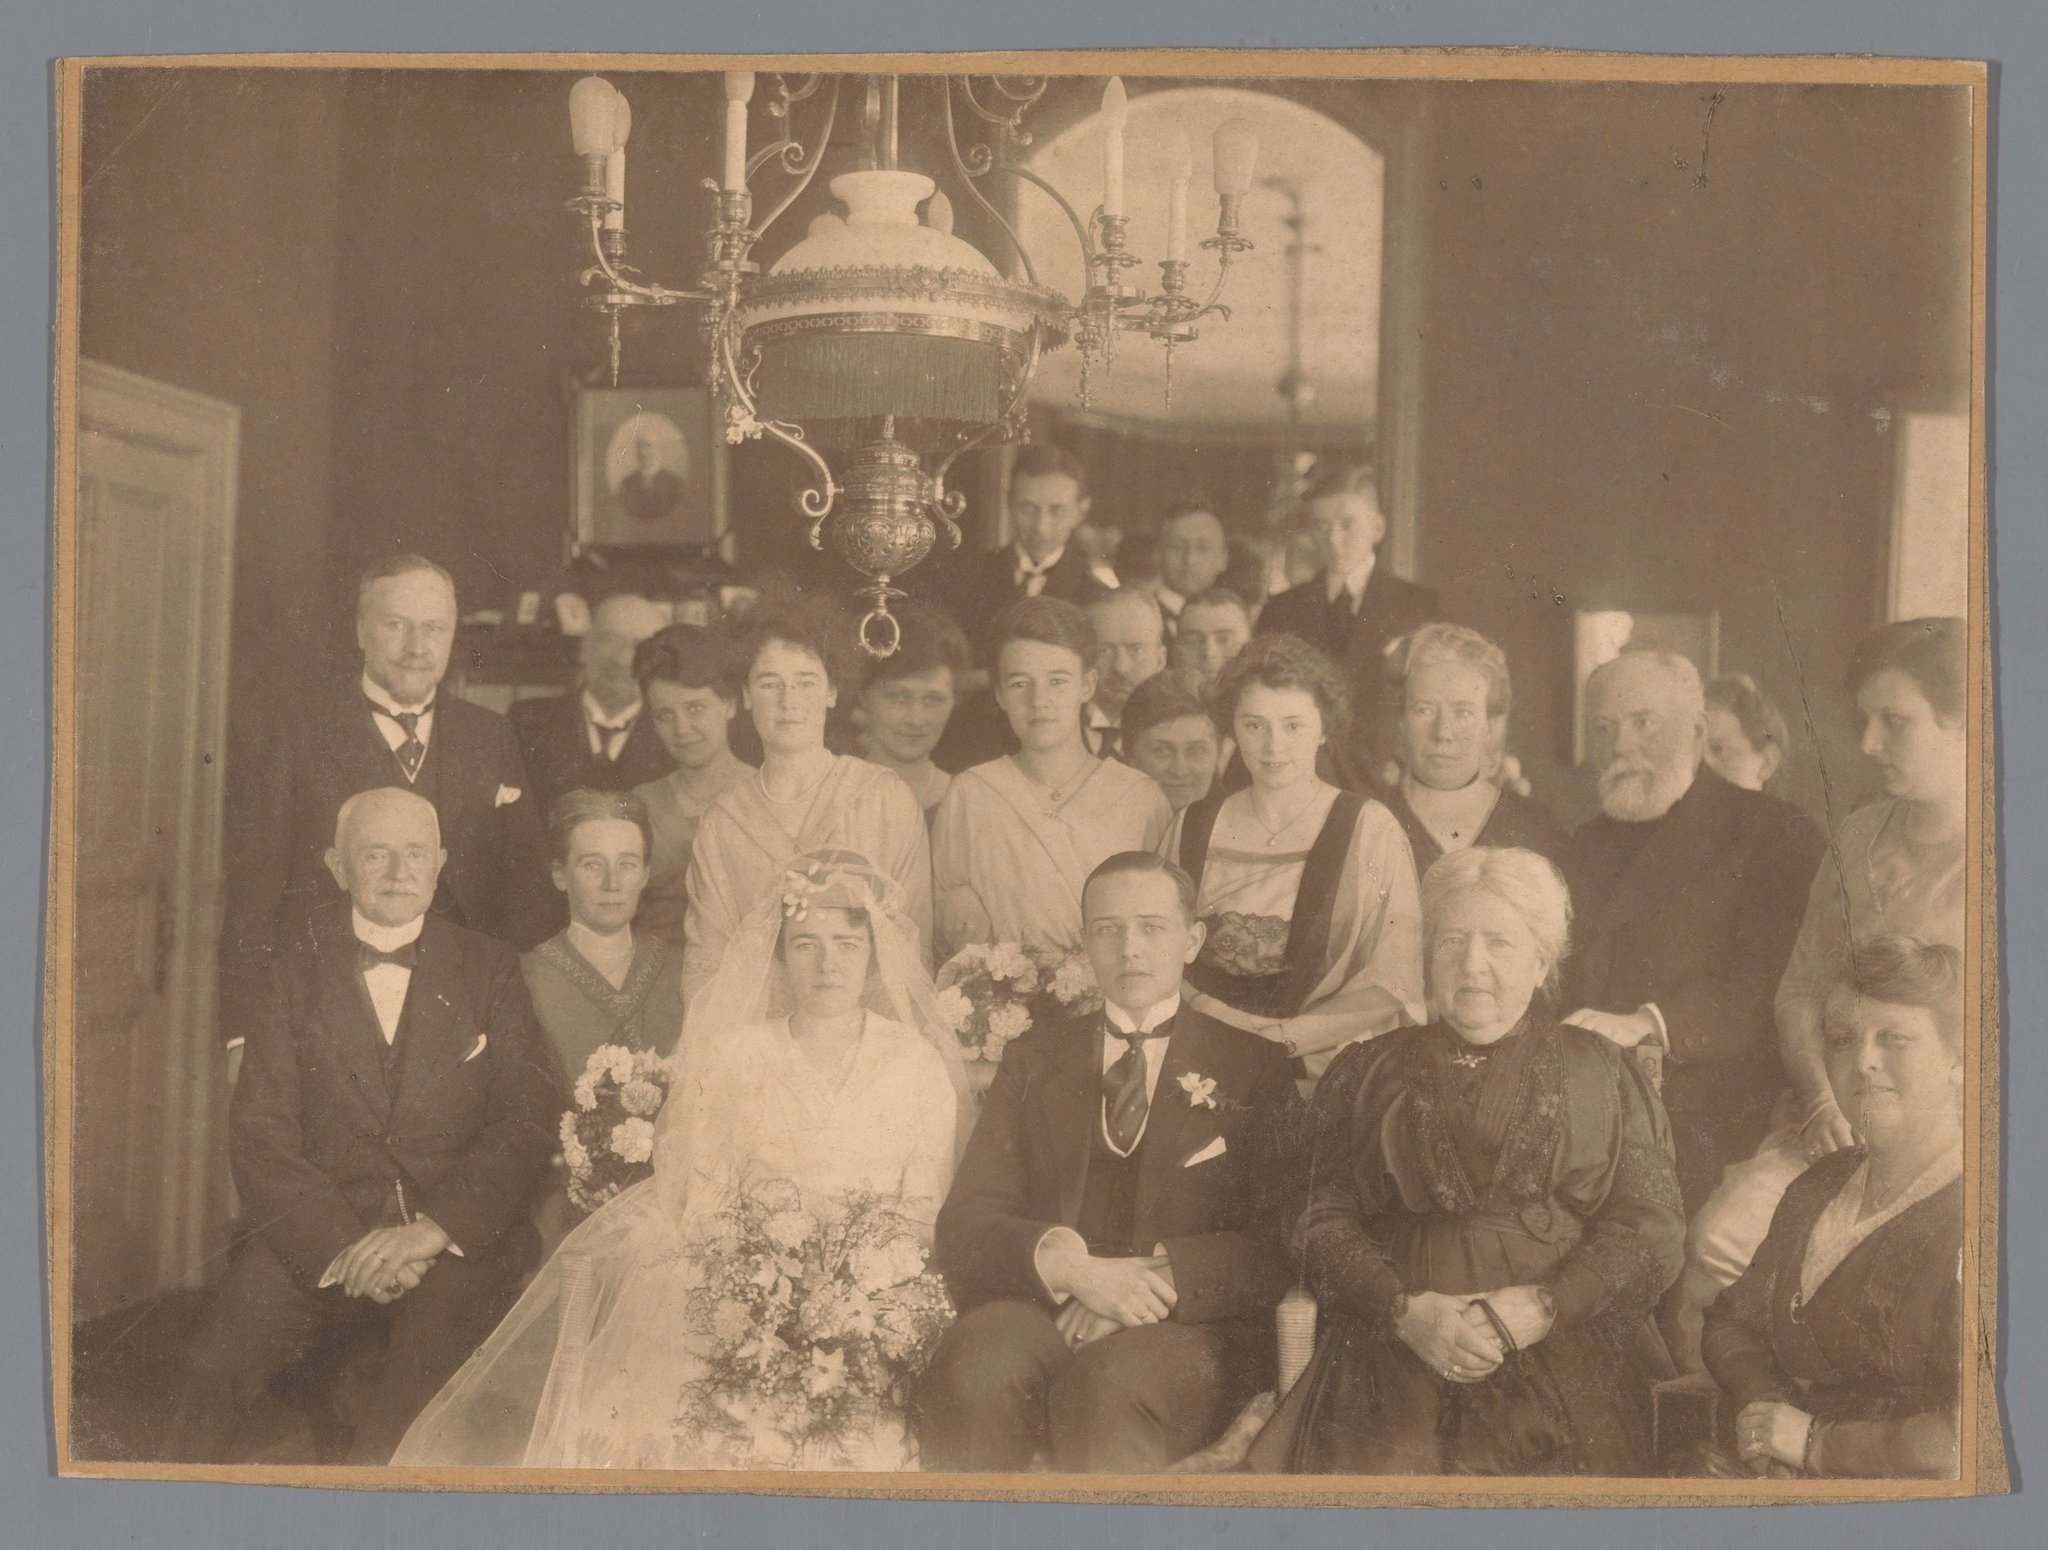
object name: photograph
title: Groepsportret met op de voorgrond een onbekend bruidspaar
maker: Anonymous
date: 1890-1920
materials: cardboard, photographic support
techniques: gelatin silver print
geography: europe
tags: (civil) marriage ceremonies